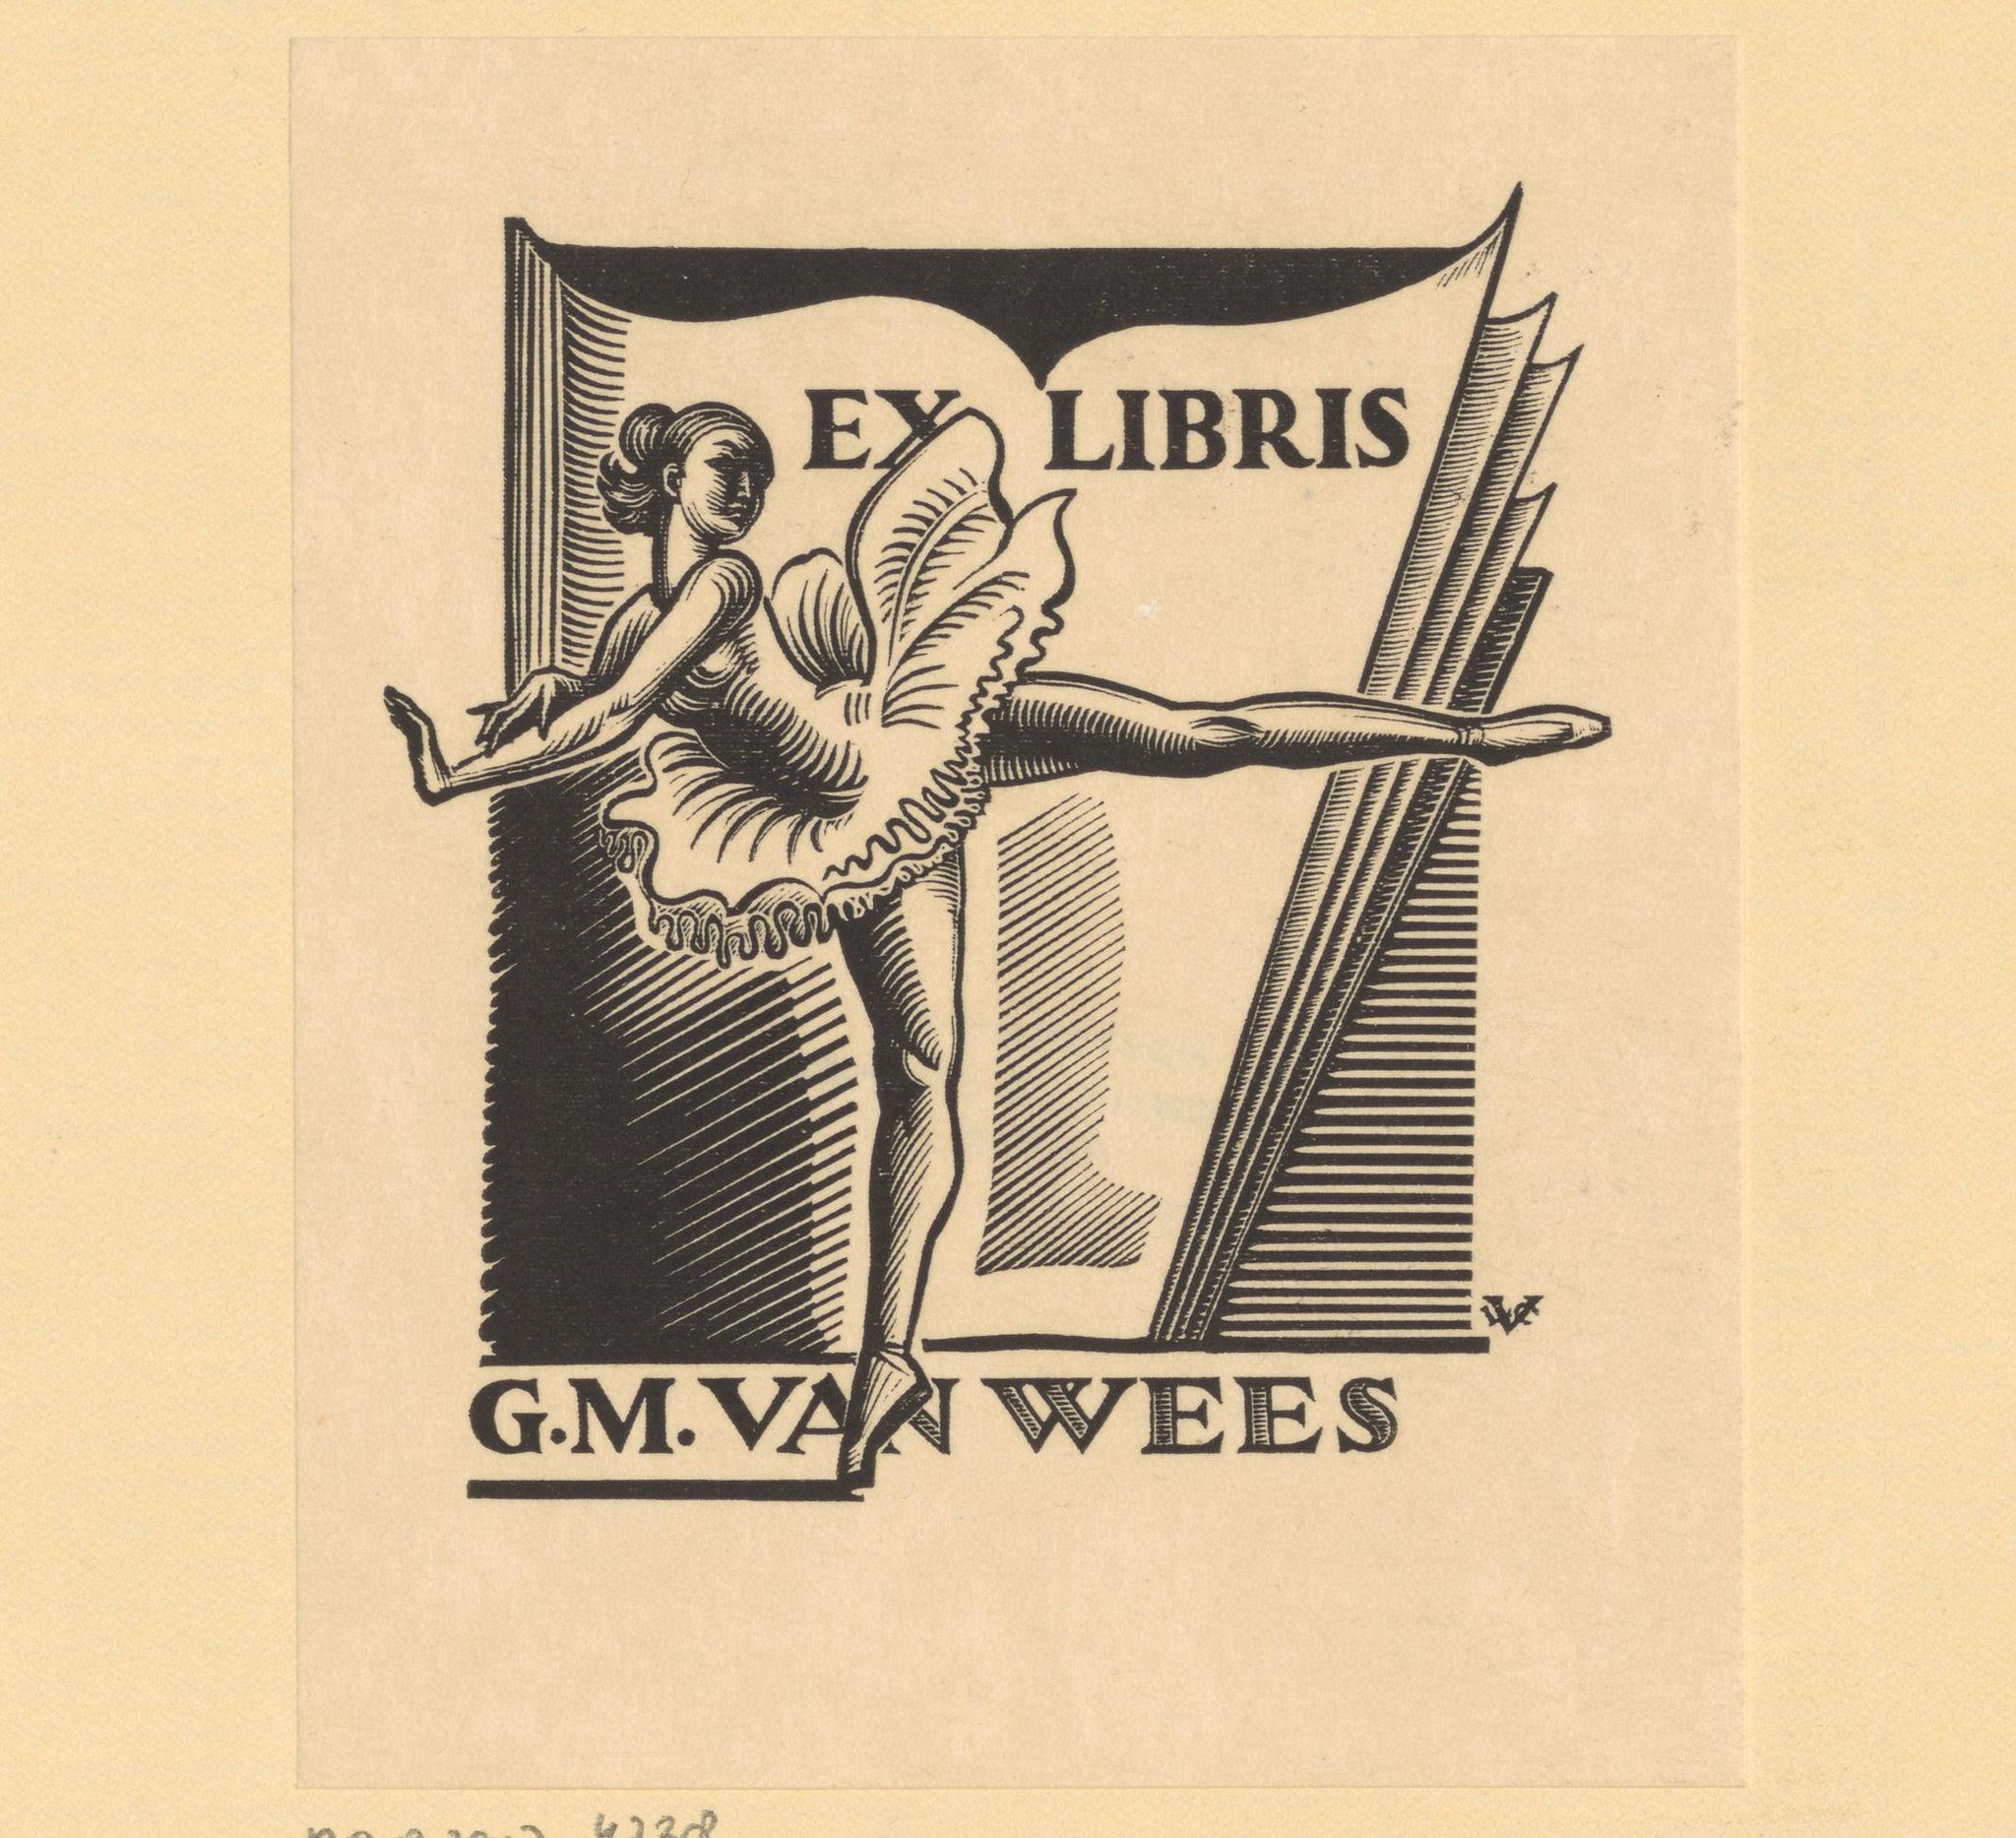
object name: bookplate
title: Ex libris van G.M. van Wees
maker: valentin le campion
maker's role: print maker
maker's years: 1861-1952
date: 1938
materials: paper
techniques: engraving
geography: paris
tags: the ballet, ballet performance, book, female dancer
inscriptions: inscription: ‘V. le Campion, 1938. hgr. (Fr.)’, workshop stamp: ‘Houtgravure / Valentin le Campion / Parijs’